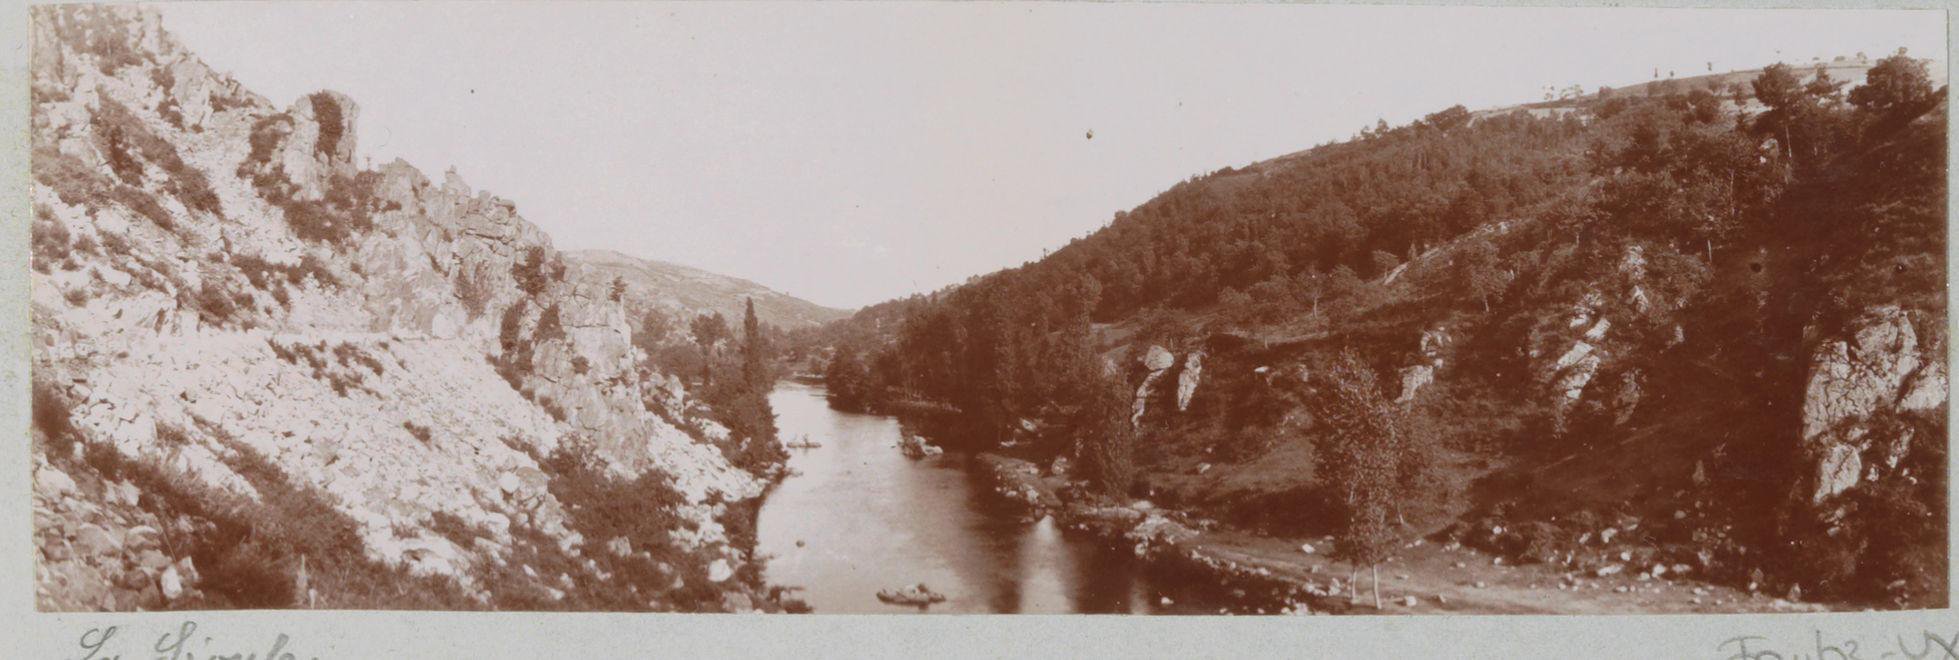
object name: photograph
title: Gezicht op de Sioule in de Auvergne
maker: delizy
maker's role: manufacturer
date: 1904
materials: paper, photographic support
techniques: gelatin silver print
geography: auvergne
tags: river (+ landscape with figures, staffage)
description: Onderdeel van Fotoalbum van een Franse amateurfotograaf met opnames van uitstapjes in Frankrijk, Spanje, België, Luxemburg en Nederland, de eerste automobielen en autoraces.